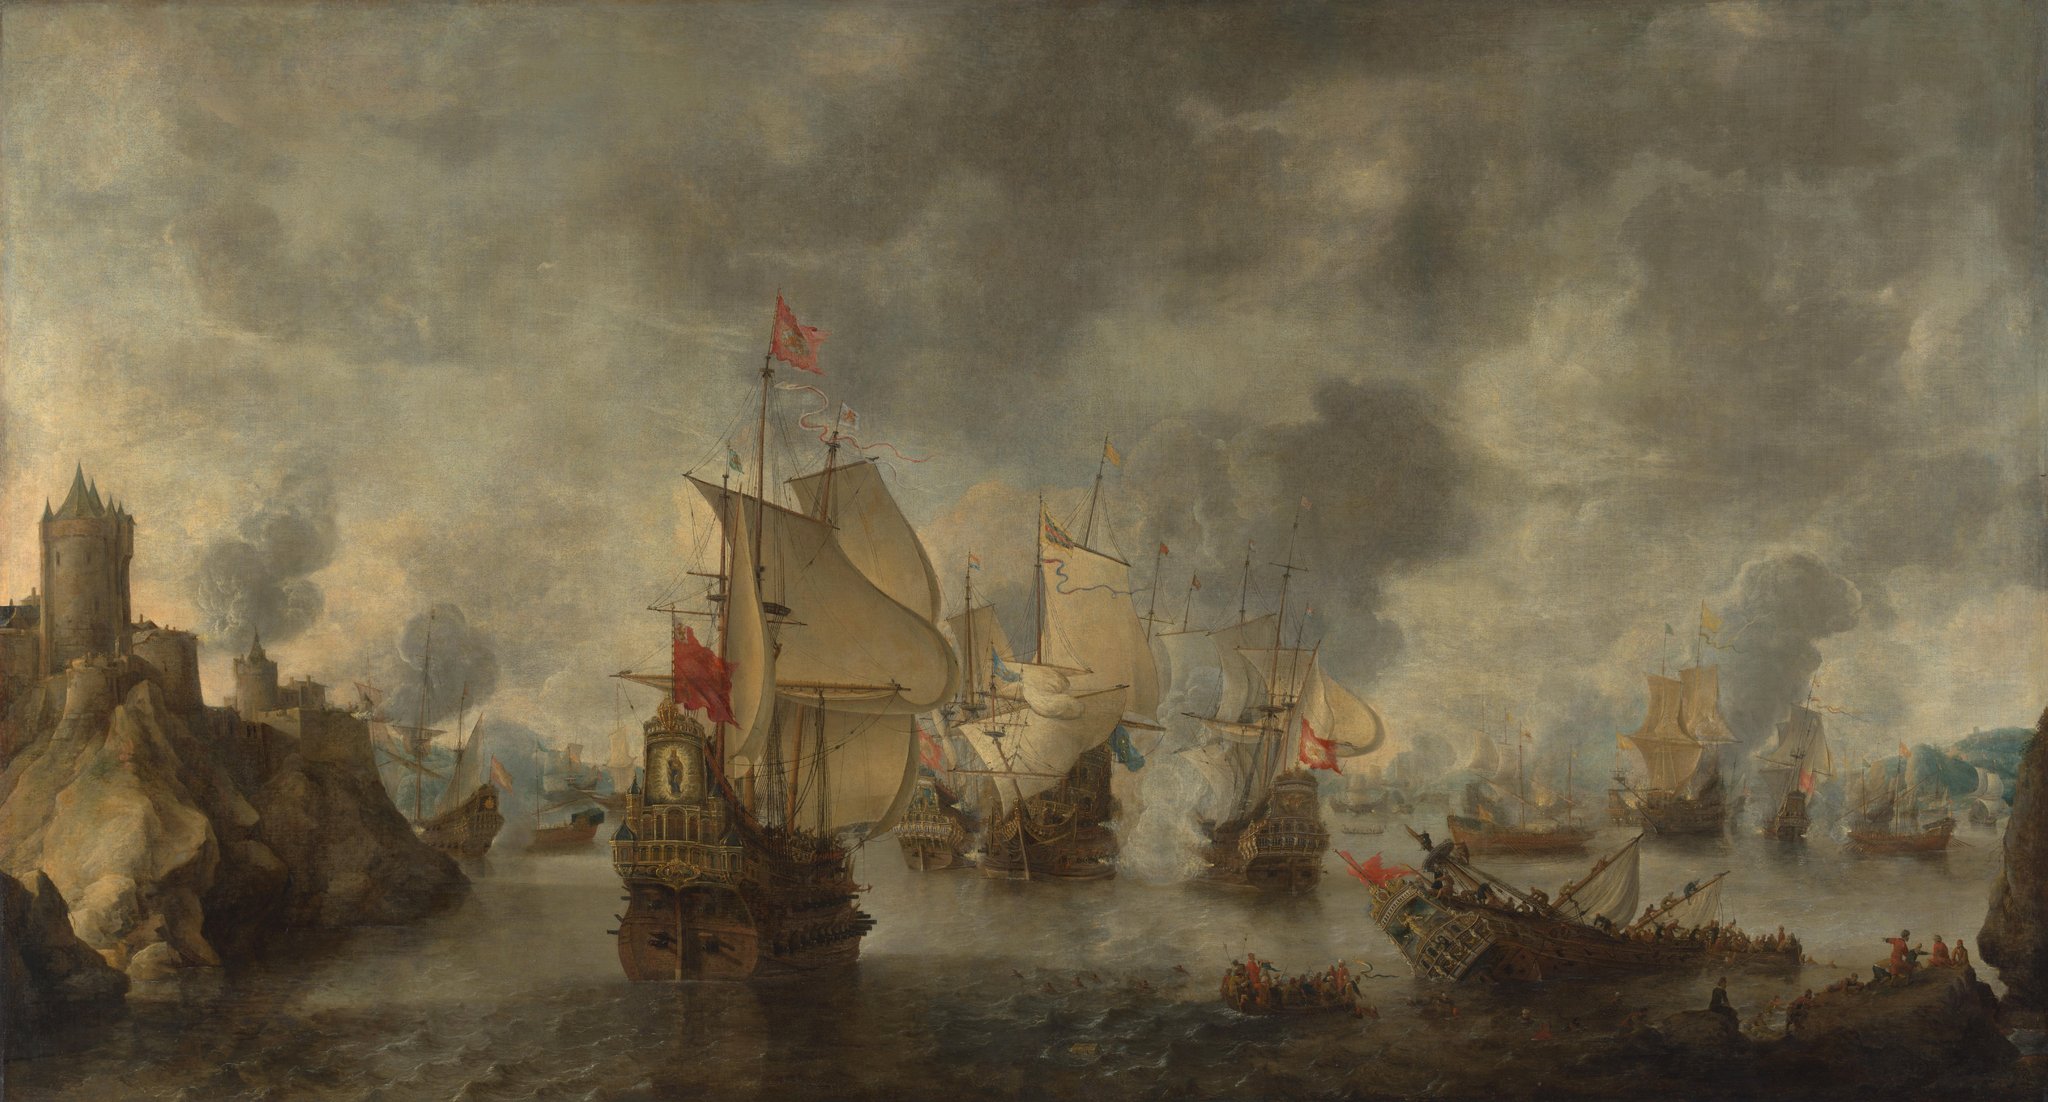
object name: painting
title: Battle of the Combined Venetian and Dutch Fleets against the Turks in the Bay of Foya, 1649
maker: abraham beerstraten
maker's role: draughtsman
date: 1656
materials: canvas, oil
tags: battle (+ sailing-ships), netherlands, italy, venice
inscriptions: signature and date: ‘AB 1656’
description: Zeeslag van de verenigde Venetiaanse en Nederlandse vloten onder bevel van Giacomo Riva tegen de Turken in de Baai van Foja, 12 mei 1649. Links de gewapende Nederlandse koopvaarder 'Madonna della Vigna'.